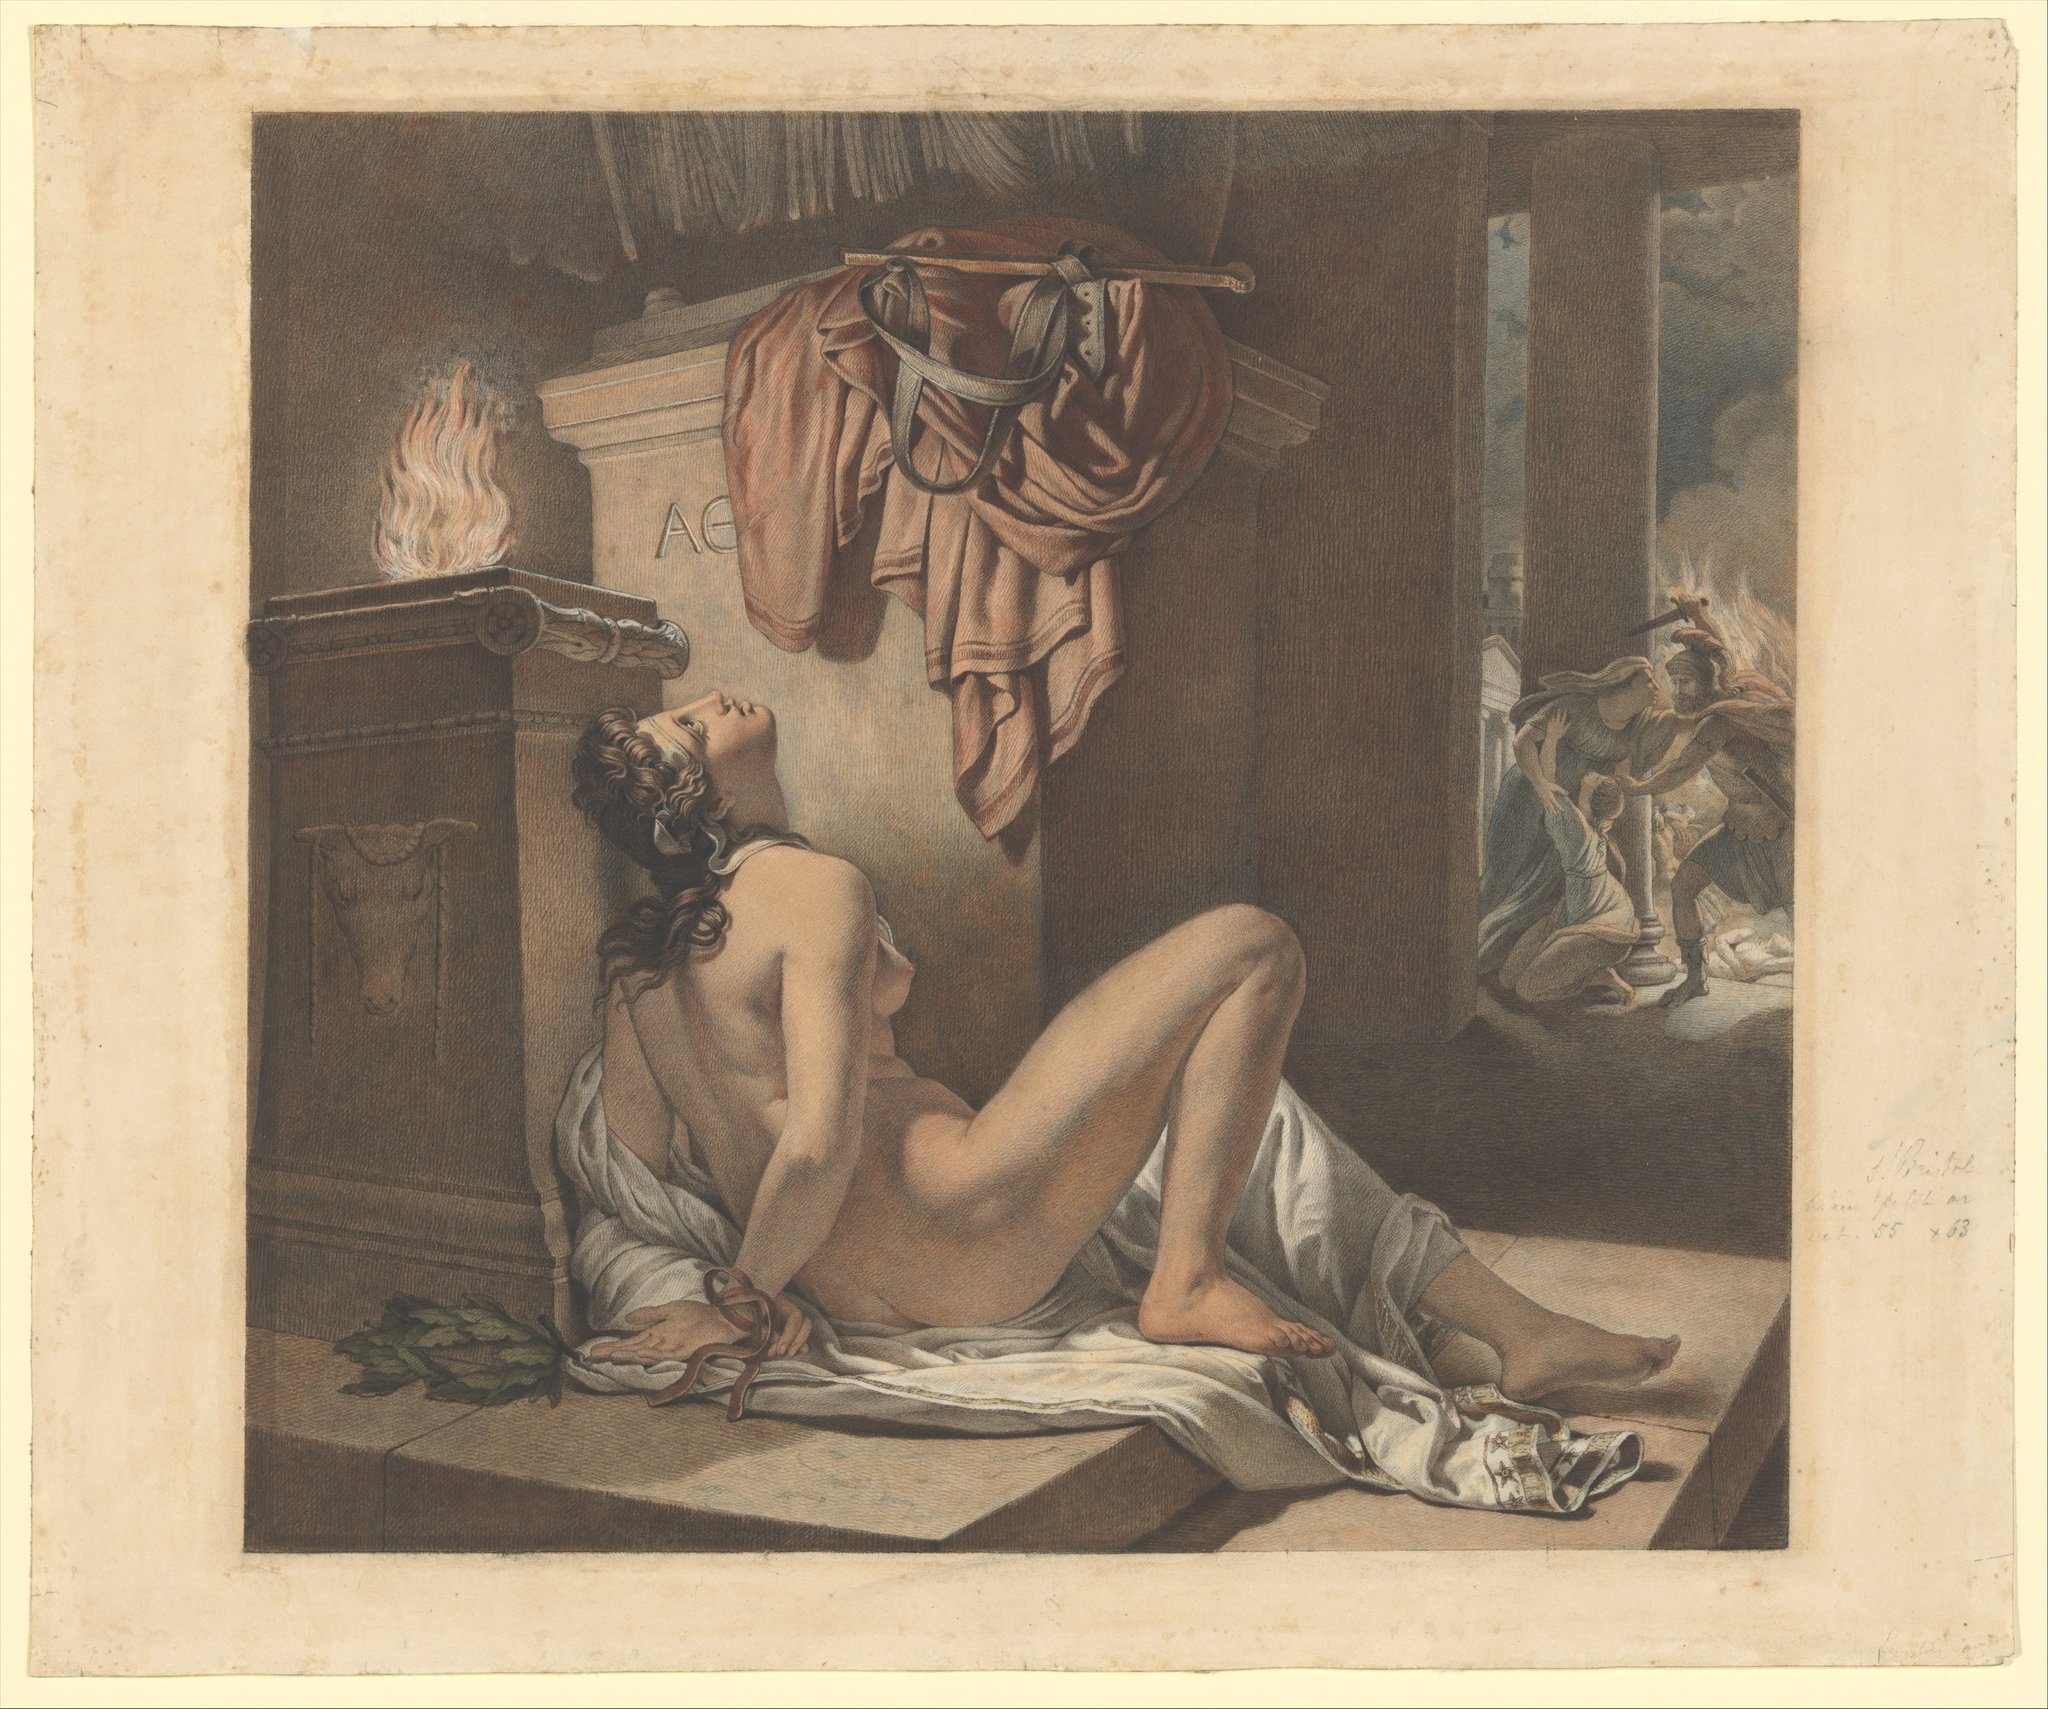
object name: drawing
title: Cassandra Imploring Athena for Revenge Against Ajax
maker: jérôme martin langlois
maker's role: artist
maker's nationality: french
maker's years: 1779-1838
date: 1810-1838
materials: chalk, lead, paint, watercolor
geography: france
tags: men,women,athena